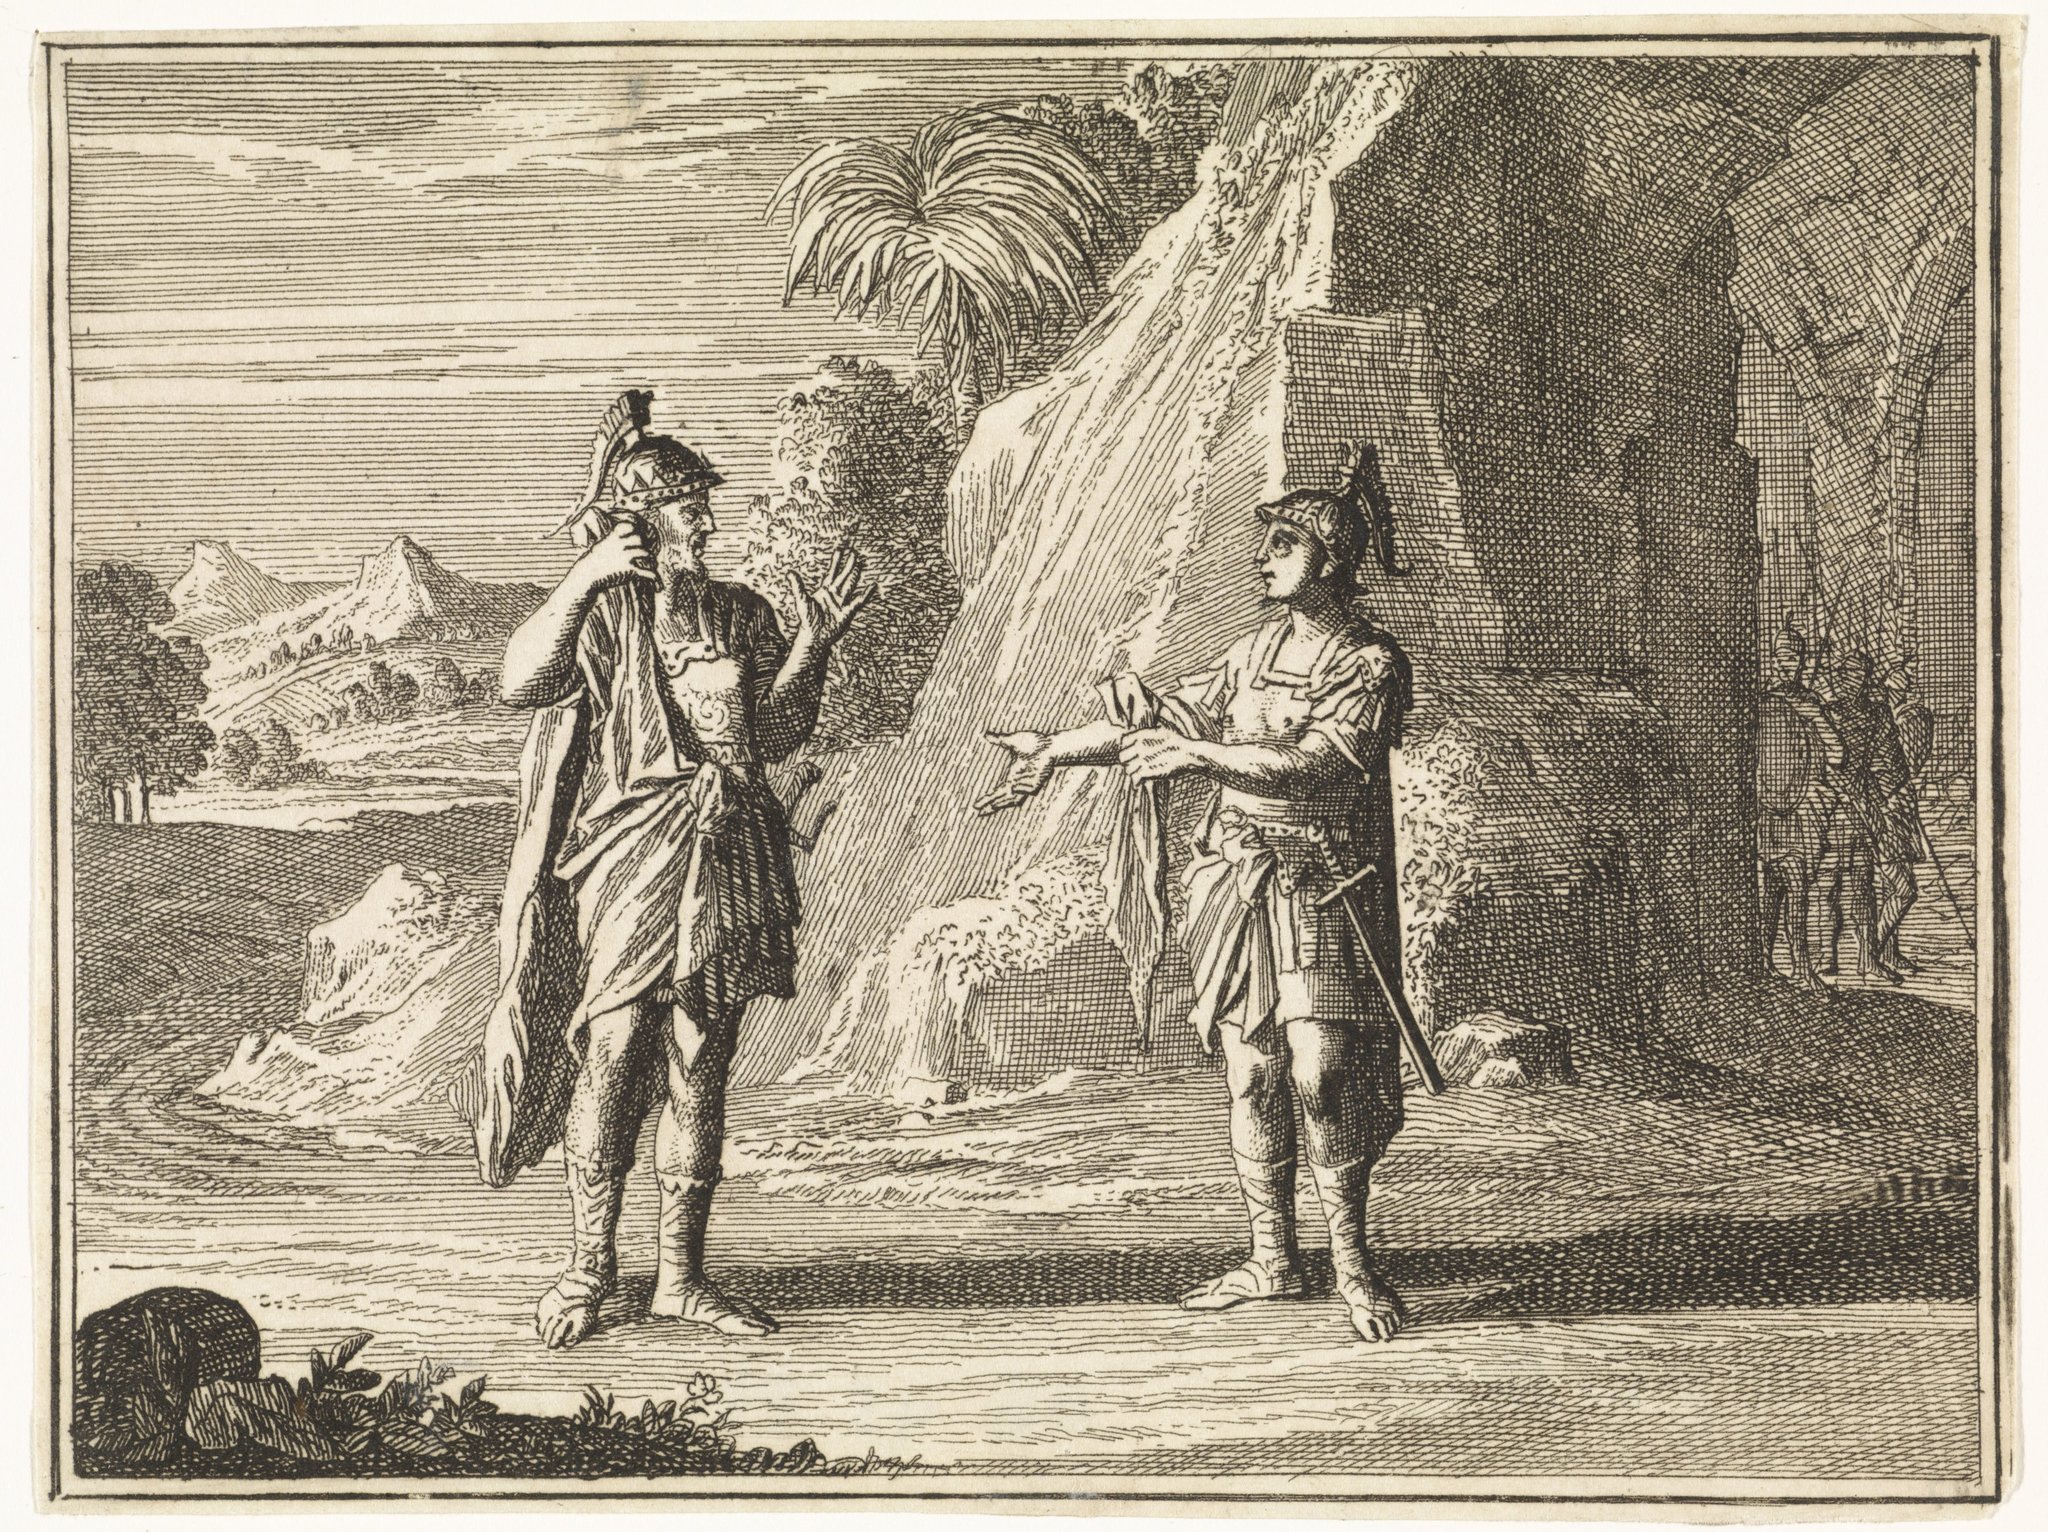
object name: print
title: David toont Saul het stuk van zijn mantel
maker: caspar luyken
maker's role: draughtsman, print maker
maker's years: 1672-1708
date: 1712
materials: paper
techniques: etching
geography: amsterdam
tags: when saul comes out of the cave, david calls him, falls down on his knees and shows him the piece of cloth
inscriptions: collector's mark: Lugt 2228, number: ‘107’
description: Illustratie uit: Luyken, Jan. De schriftuurlyke geschiedenissen en gelykenissen van het Oude en Nieuwe Verbond, 2 delen. Amsterdam: Wed. Pieter Arentsz II en Cornelis van der Sys, 1712, dl. I.